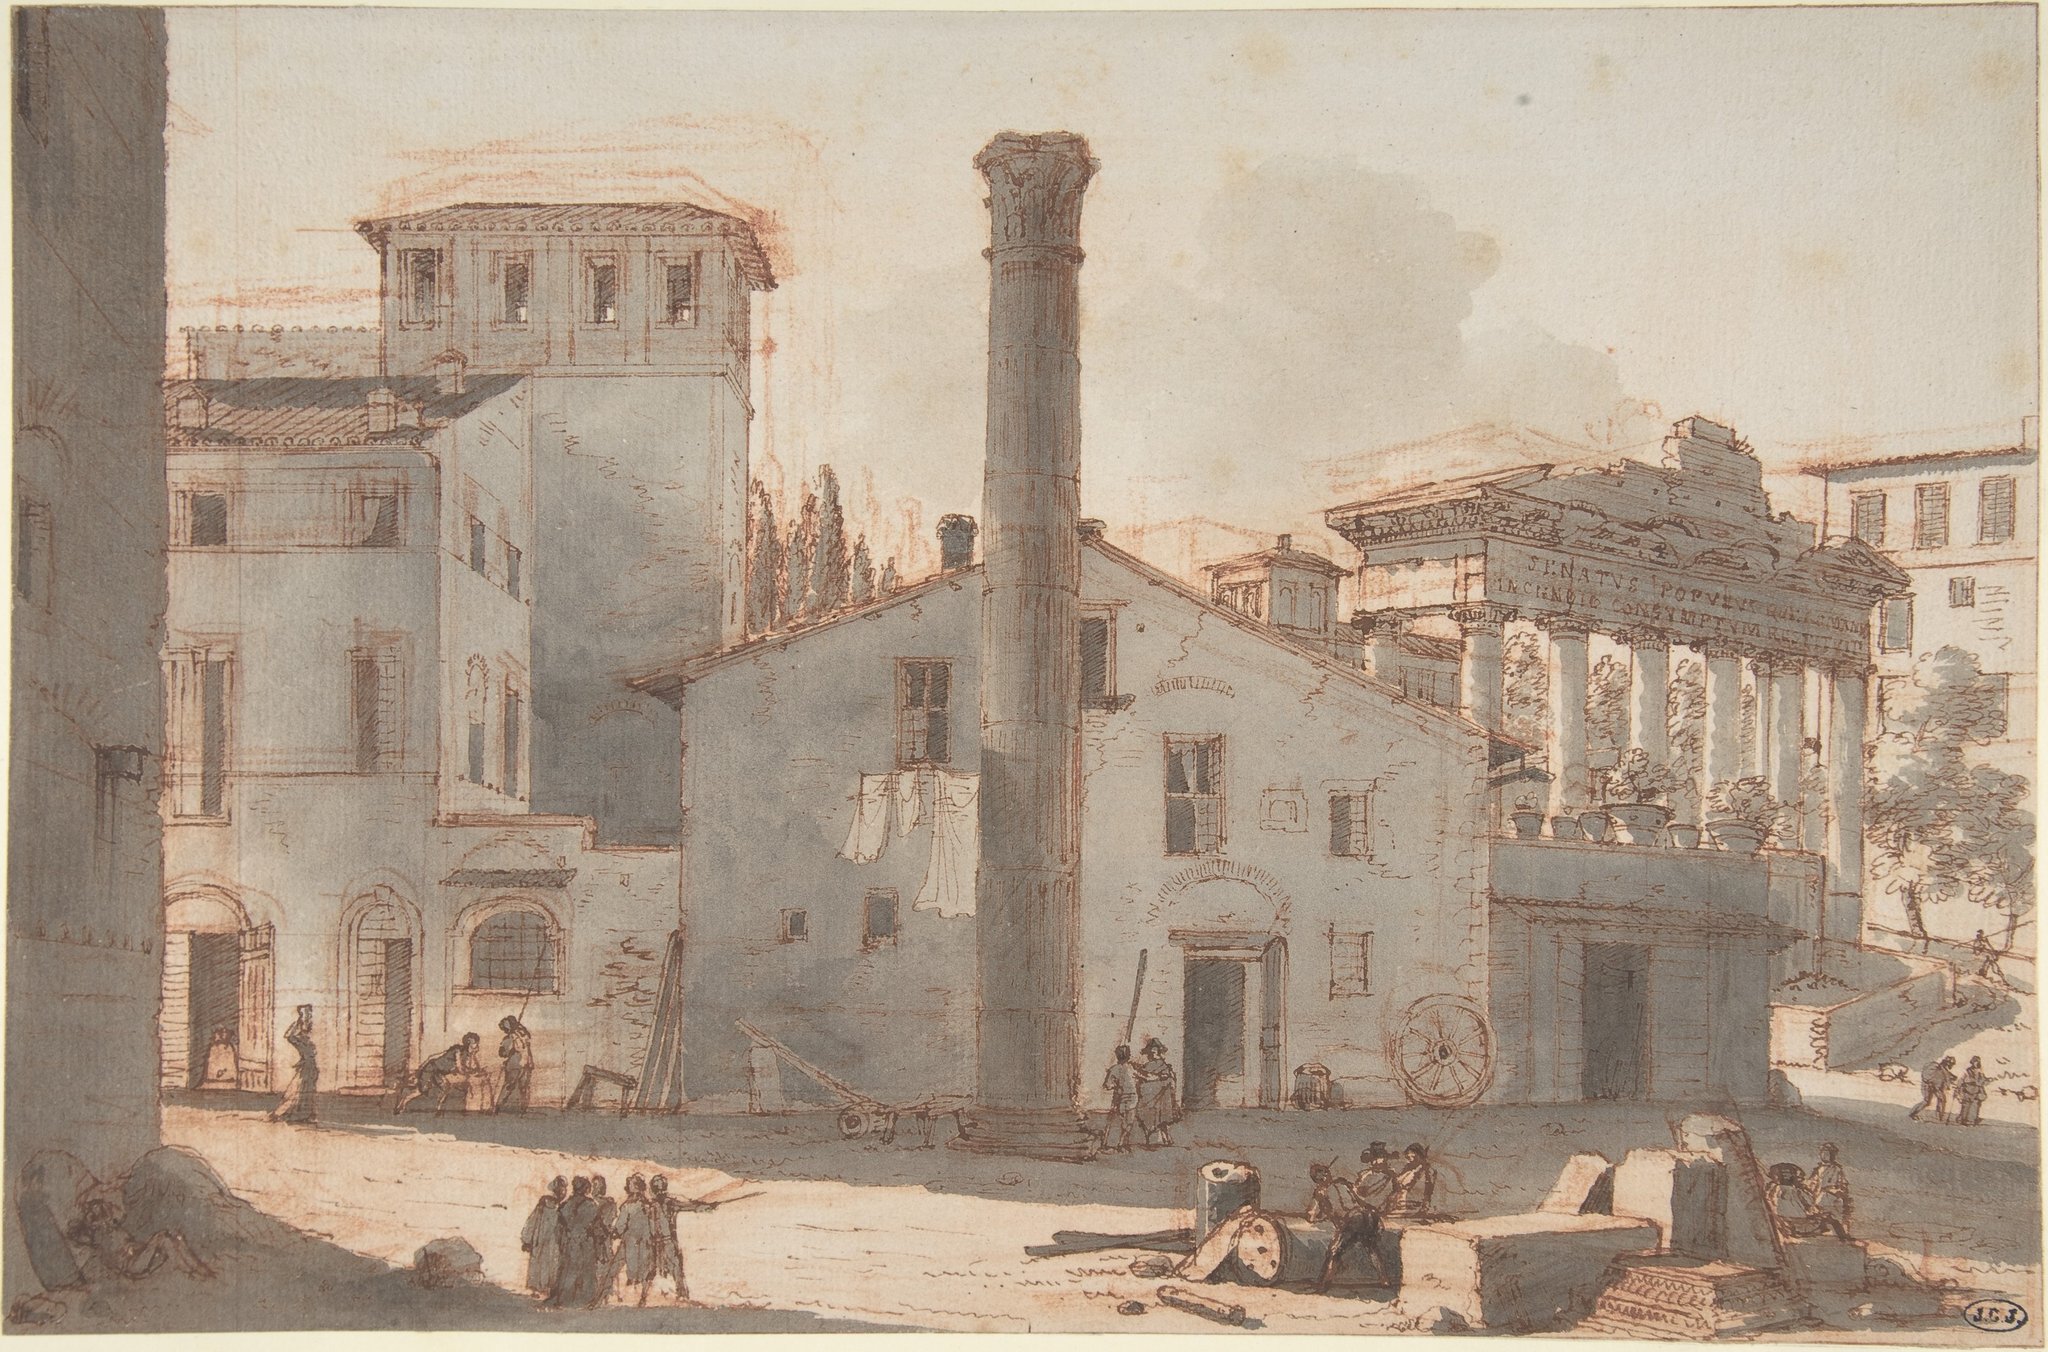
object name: drawing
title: View of the Roman Forum with the Column of Phocas and the Temple of Saturn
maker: victor jean nicolle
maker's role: artist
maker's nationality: french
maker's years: 1754-1826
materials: chalk, ink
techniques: brush, pen, wash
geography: france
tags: columns,temples,rome